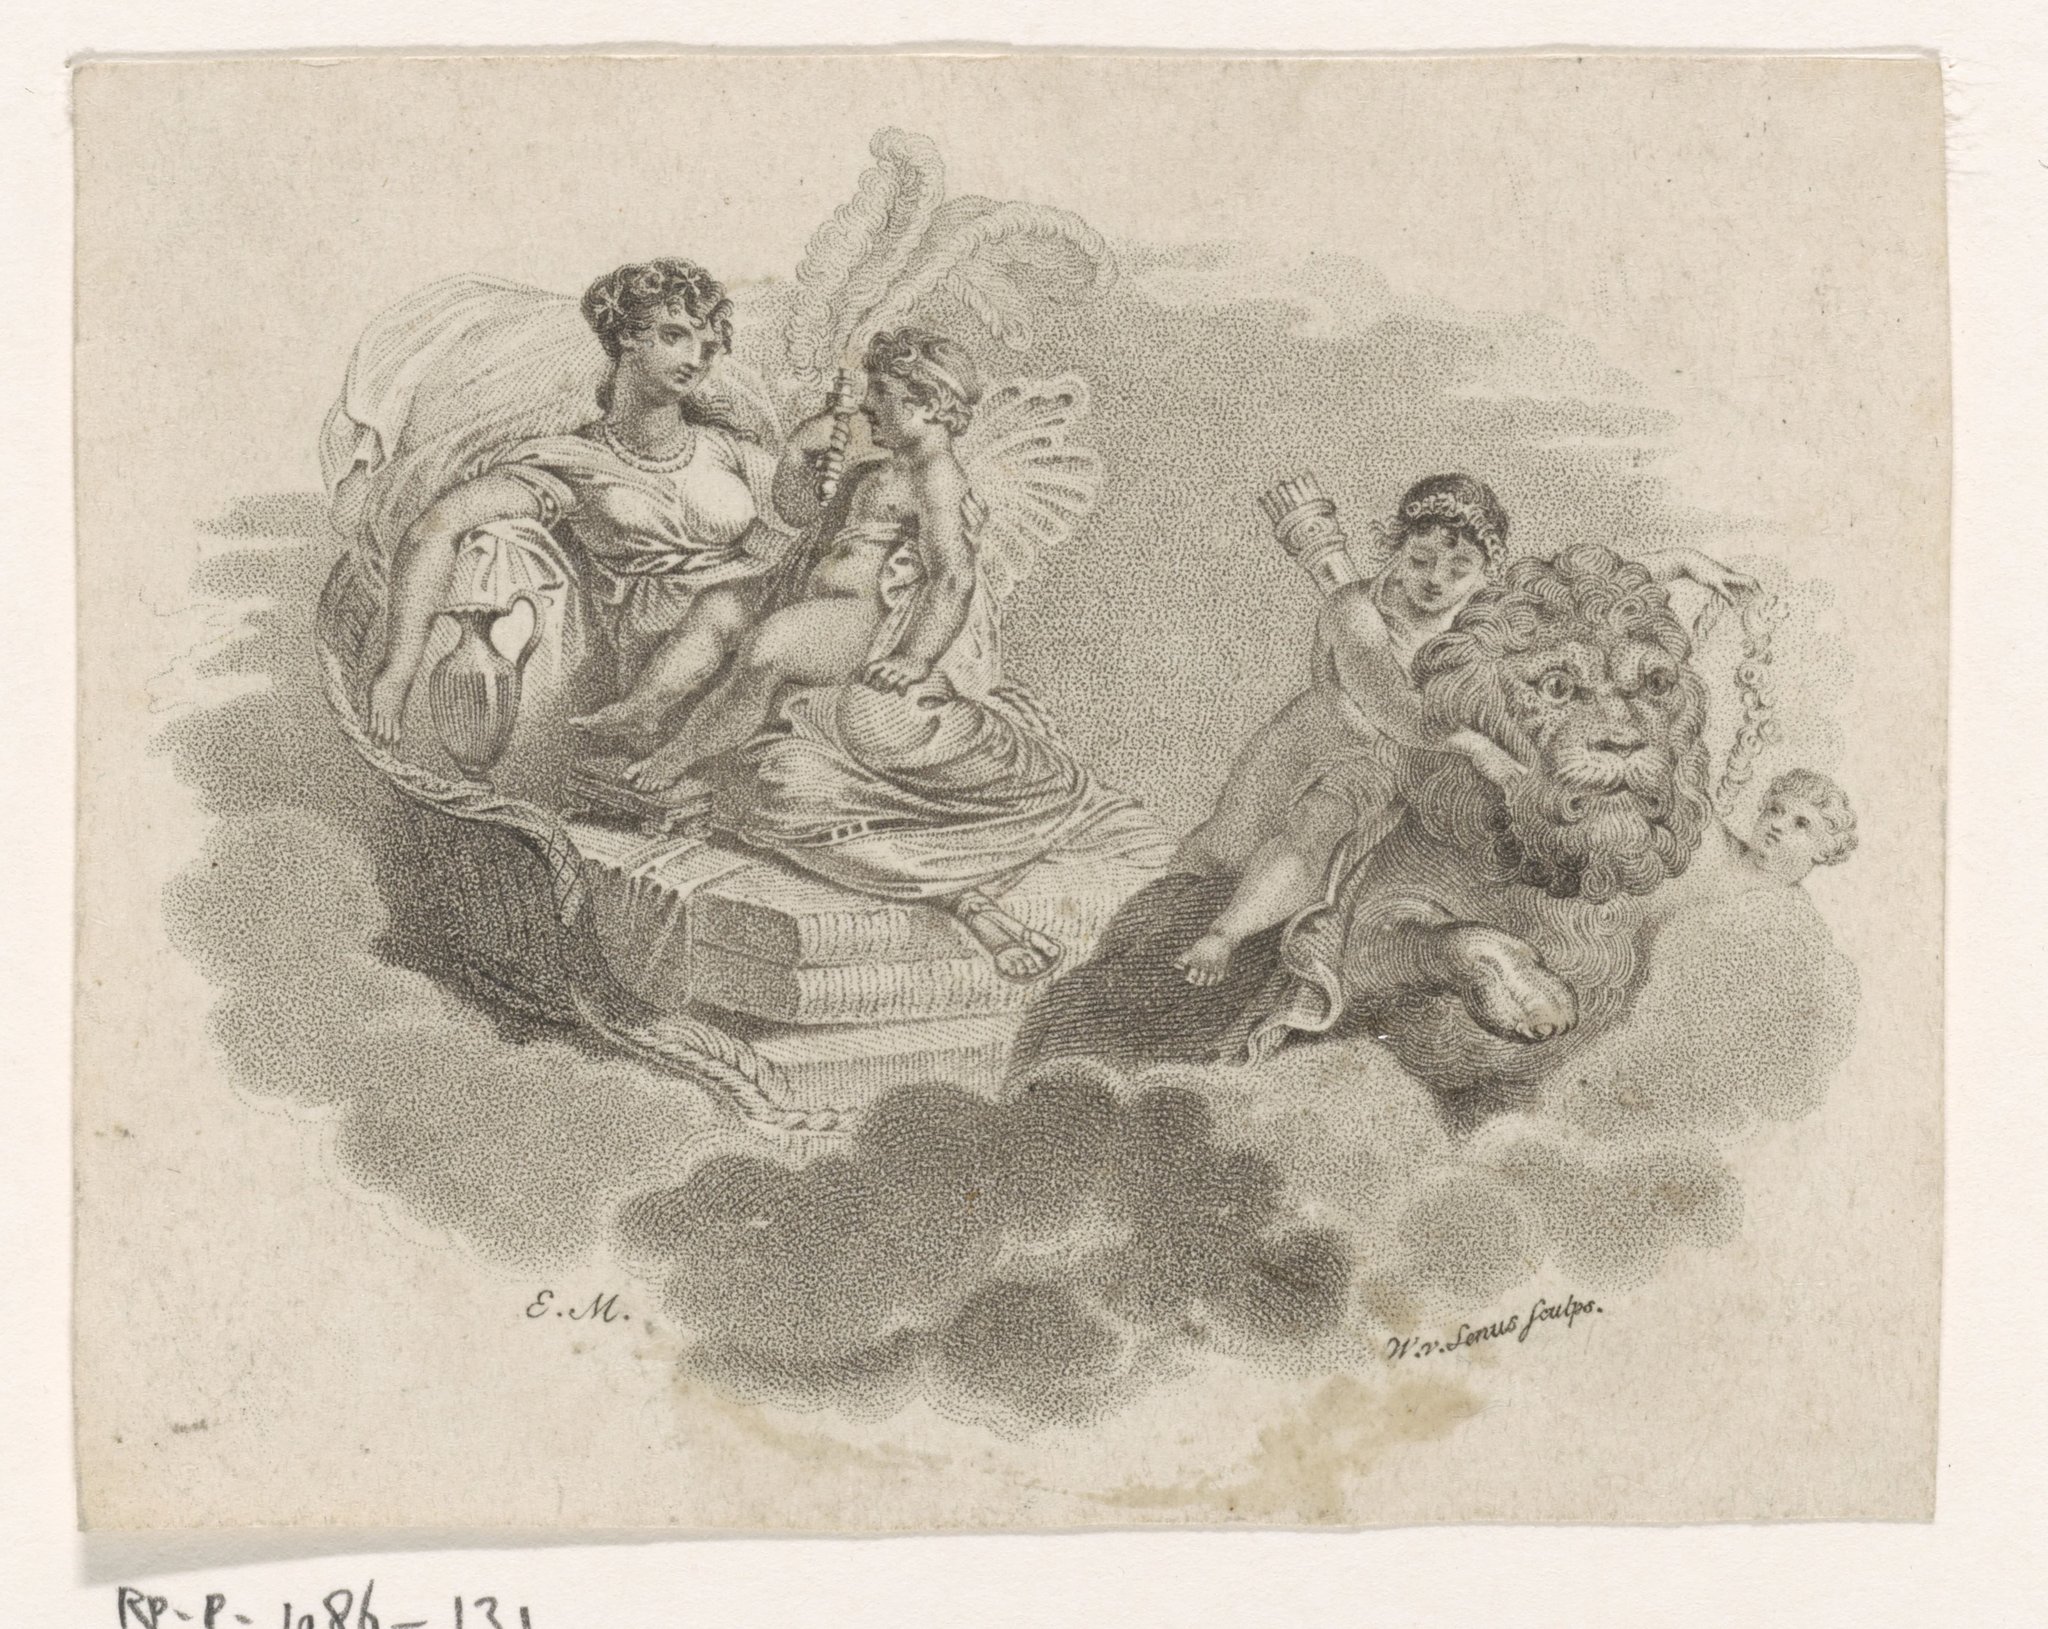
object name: print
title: Vrouw op een ligbed met putti en een leeuw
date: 1783-1851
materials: paper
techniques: etching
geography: netherlands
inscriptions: collector's mark: Lugt 2760, collector's mark: Lugt 2228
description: Een vrouw op een ligbed tussen de wolken omringd door putti en een leeuw.